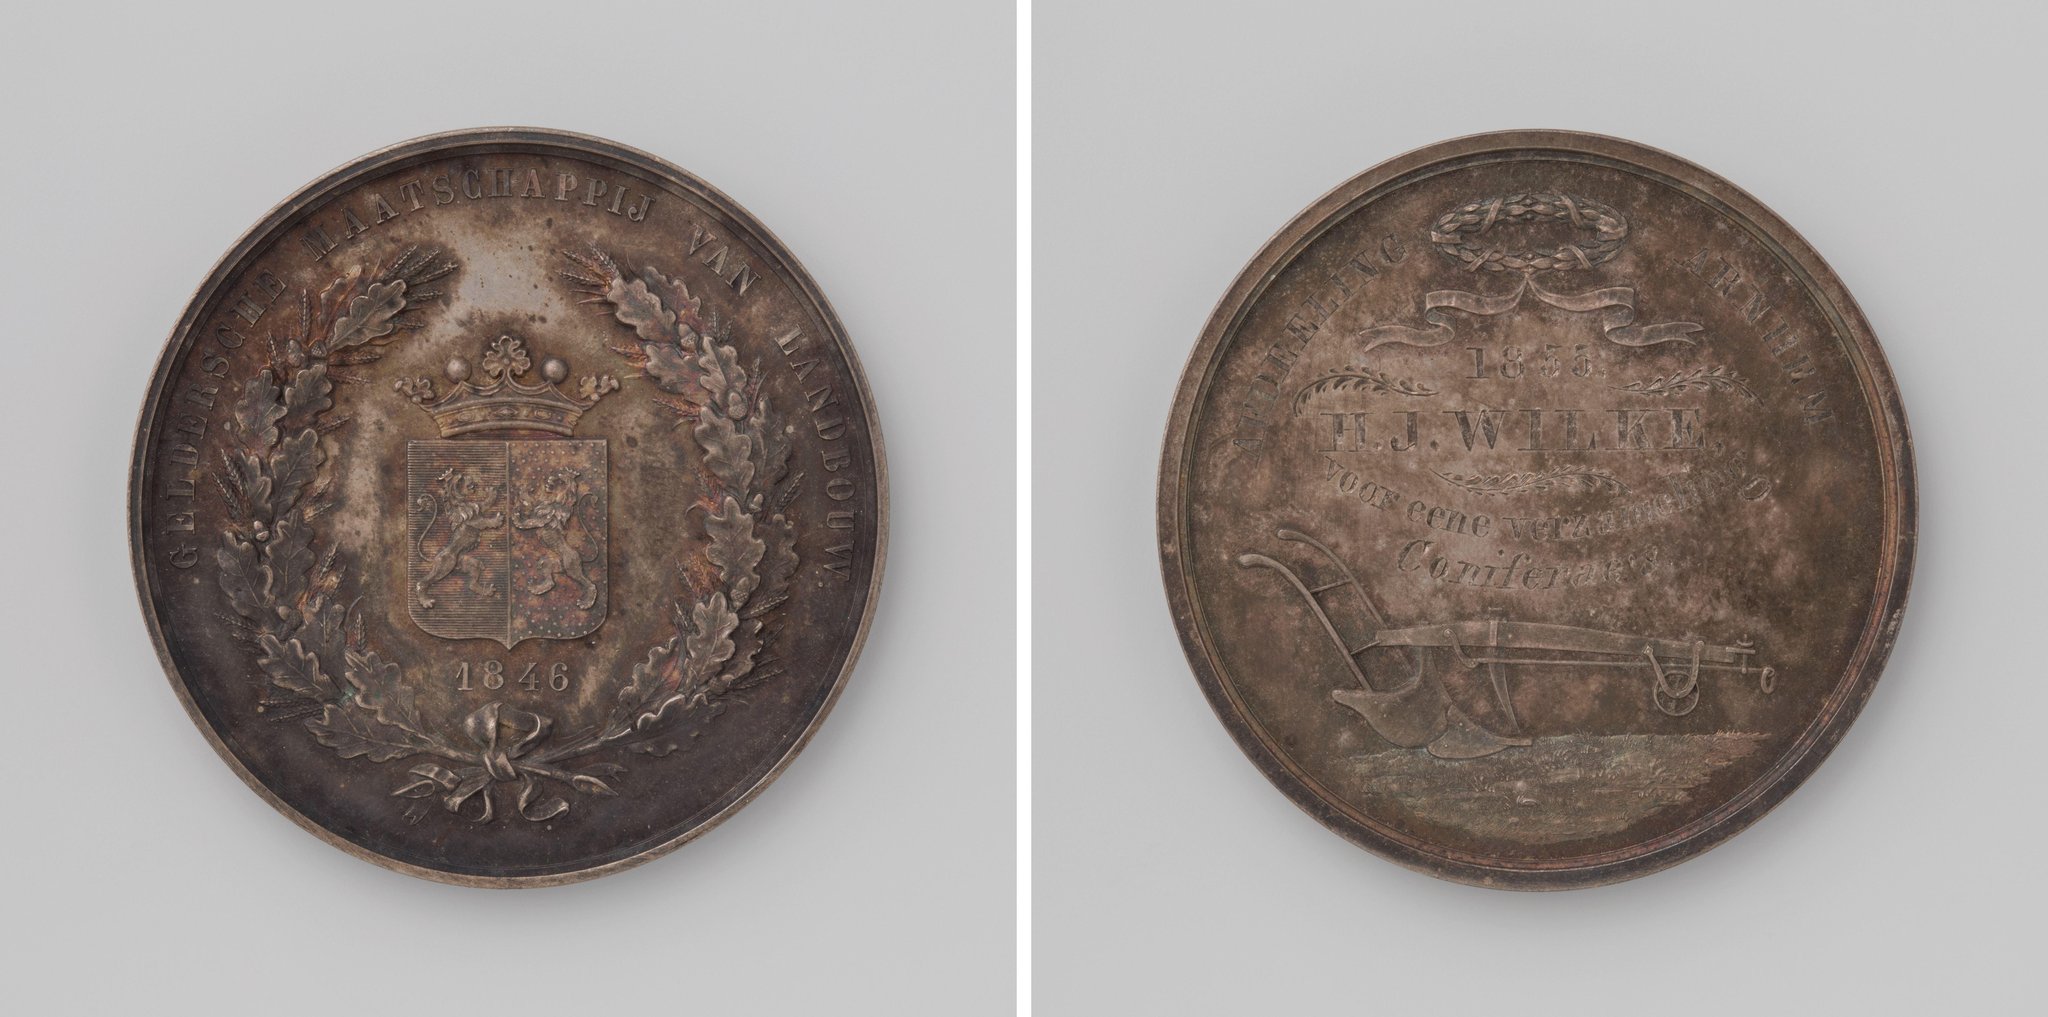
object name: medal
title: Afdeling Arnhem van de Geldersche Maatschappij van Landbouw, penning uitgereikt aan H.J. Wilke, vanwege zijn verzameling coniferen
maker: Anonymous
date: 1846-1855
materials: silver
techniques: striking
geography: netherlands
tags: gelderland, arnhem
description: Zilveren penning. Voorzijde: gekroond wapenschild boven jaartal binnen krans van eiketakken en korenaren en omschrift. Keerzijde: opschrift onder krans van olijftakken met lint, boven ploeg